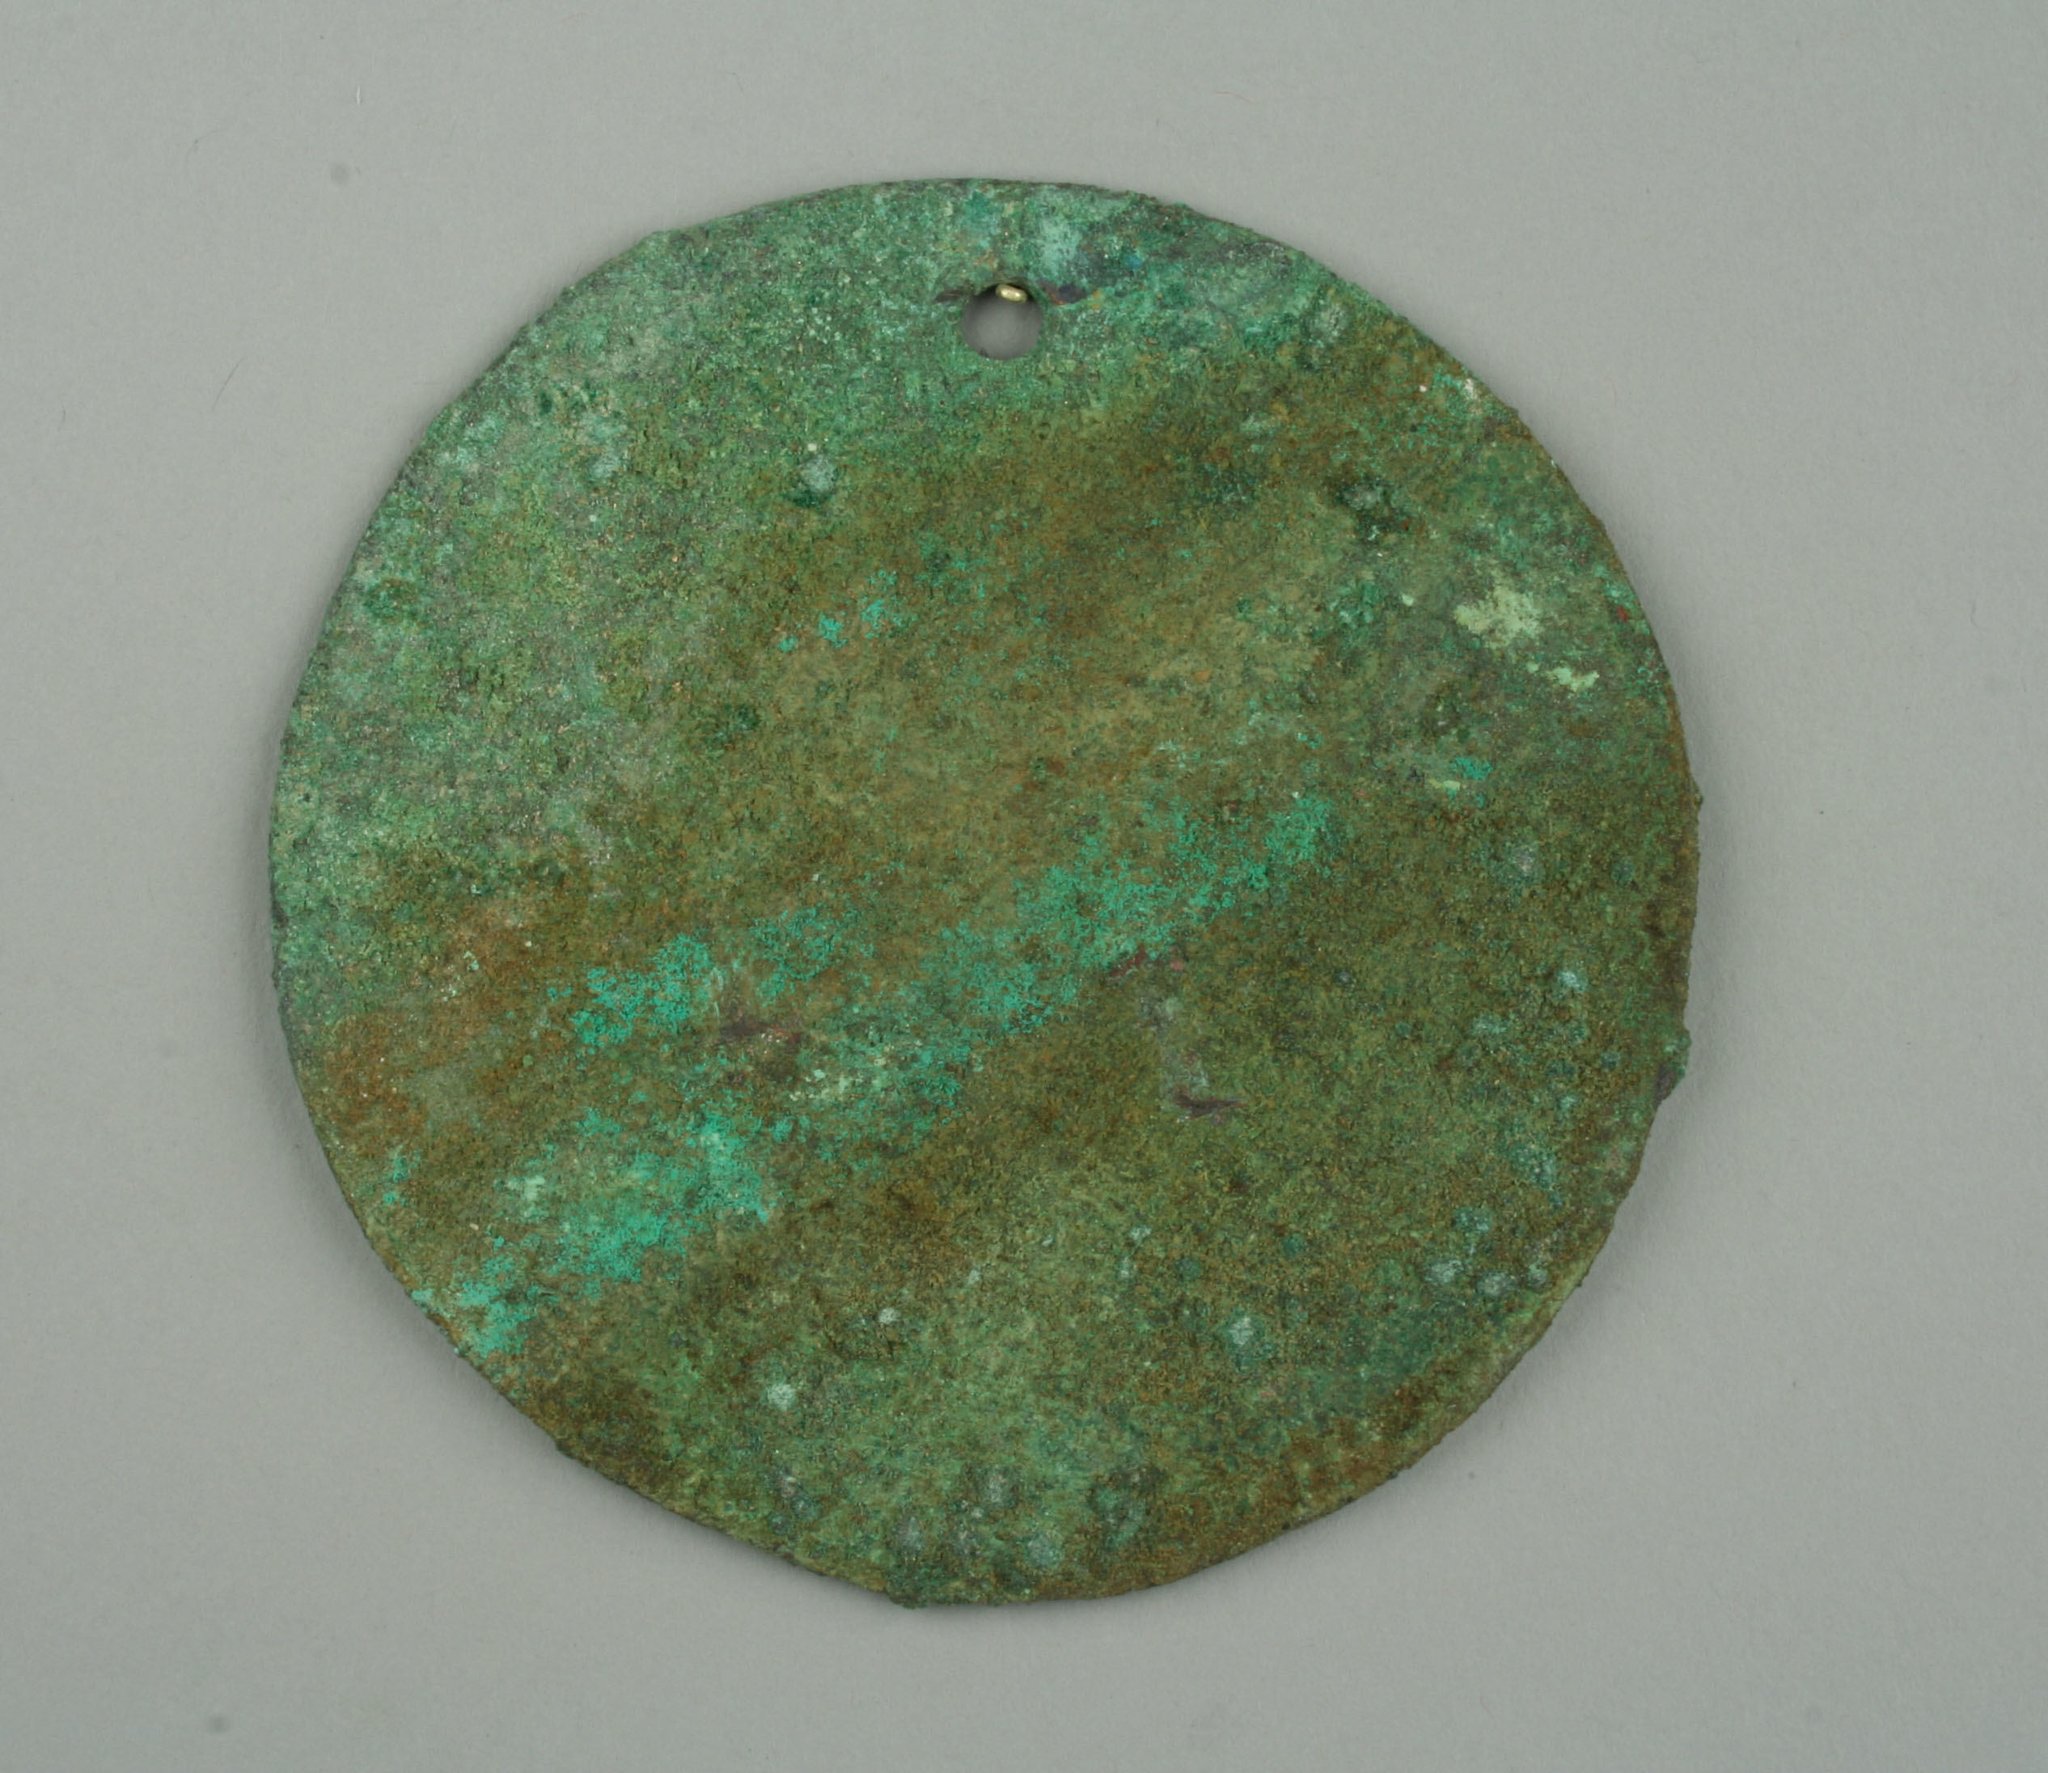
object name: plaque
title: Round Plaque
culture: vicús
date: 300 BCE-200 CE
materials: copper, gilt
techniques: hammering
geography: peru